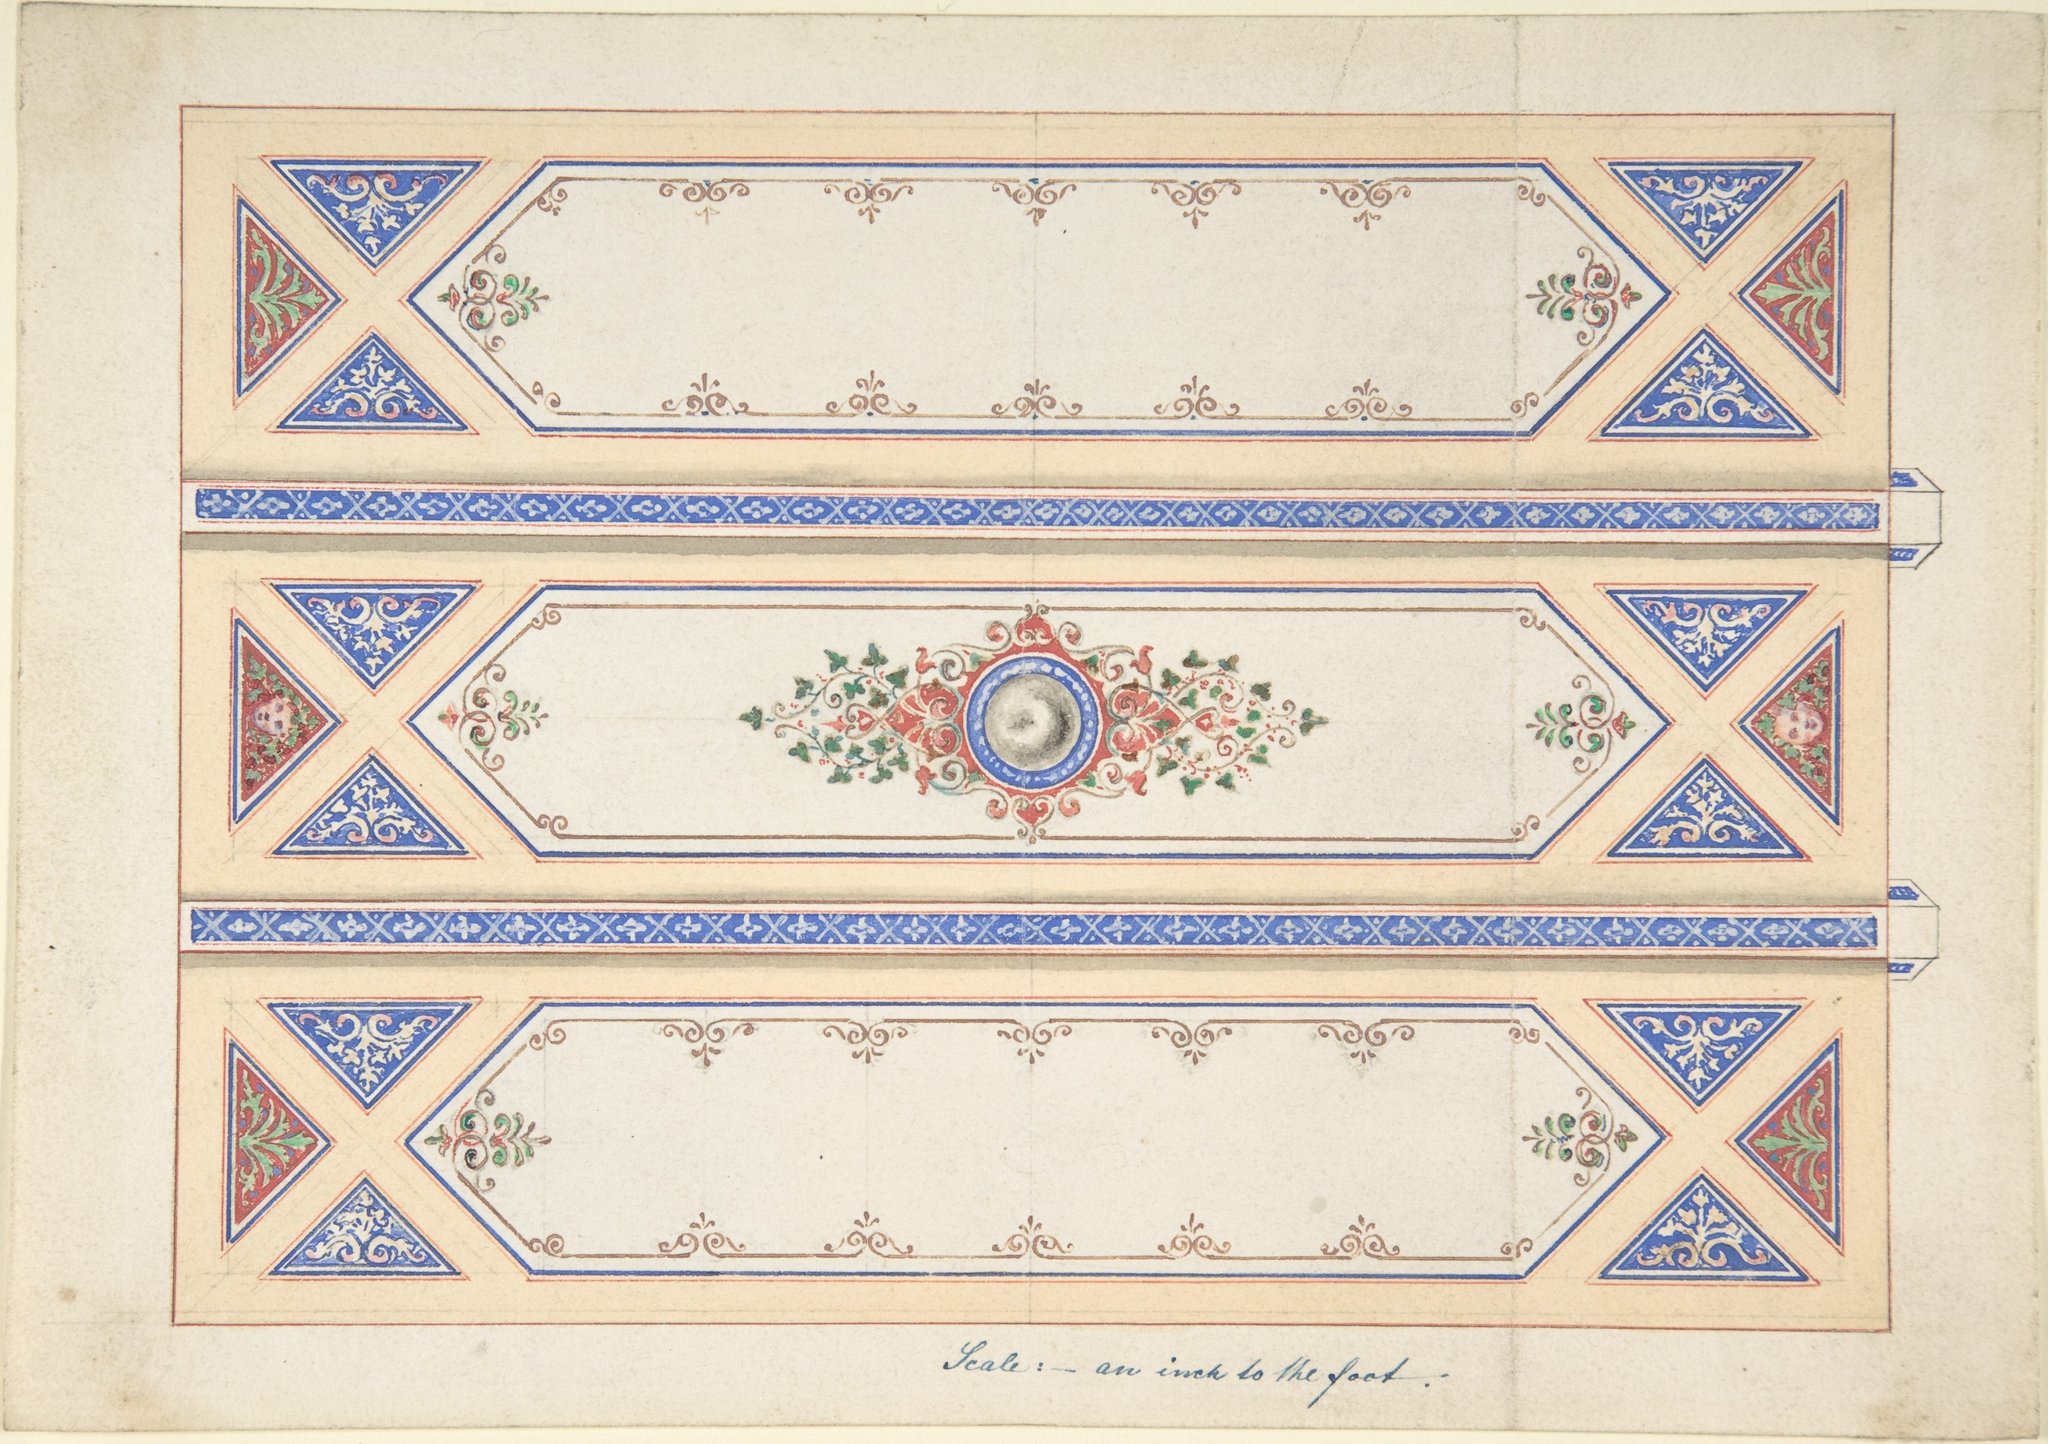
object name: drawing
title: Ceiling Design with Three Panels Divided by Beams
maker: anonymous, british, 19th century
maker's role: artist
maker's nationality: british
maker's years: 1800-1900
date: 1801-1900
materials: watercolor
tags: ornament,ceilings